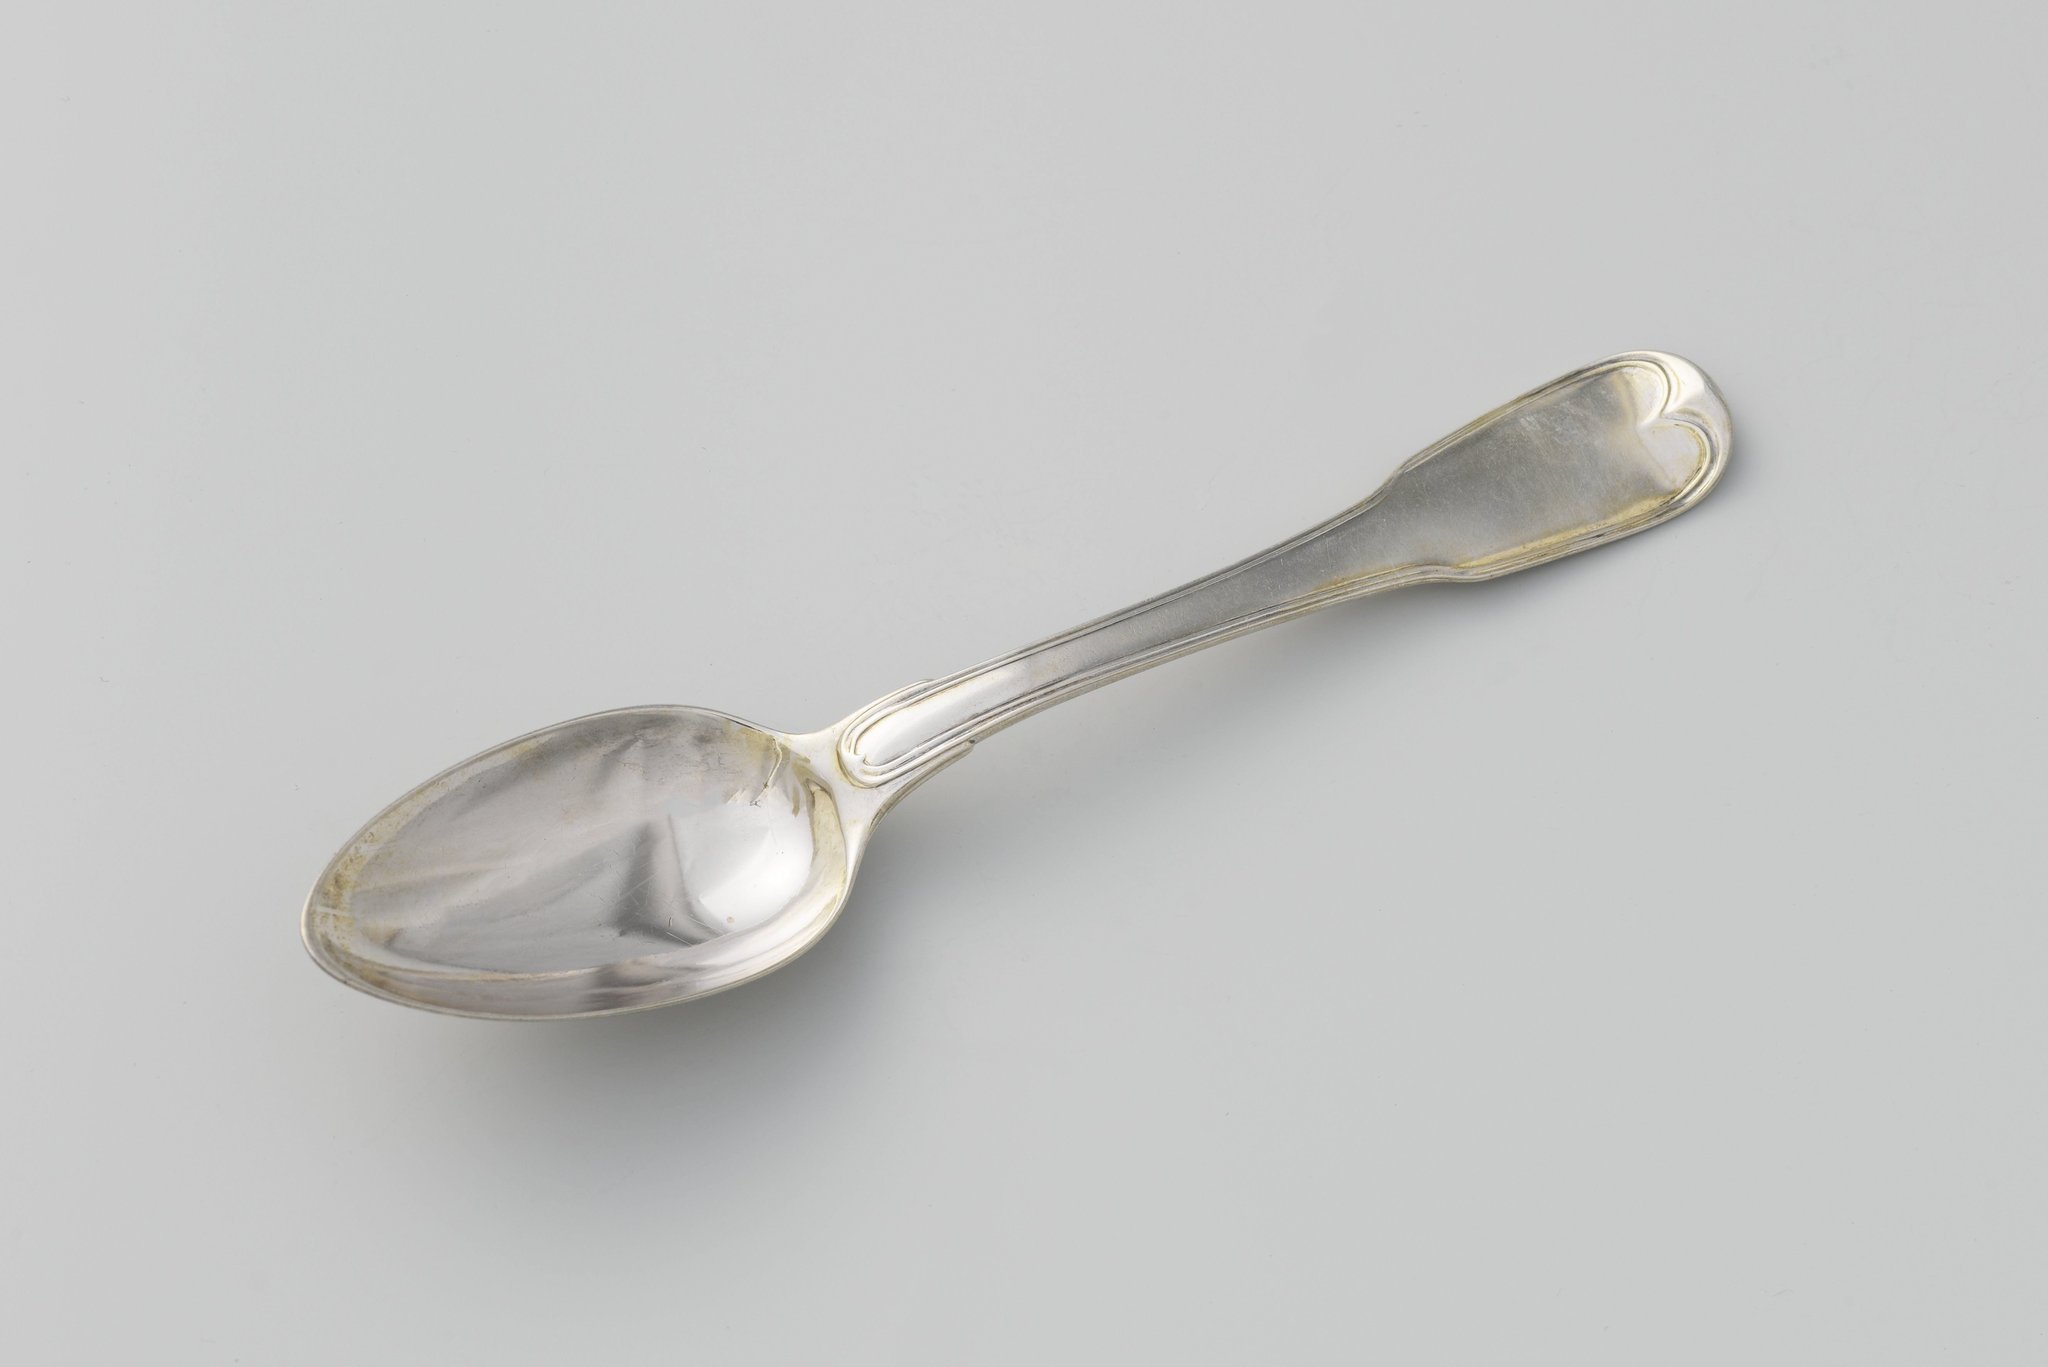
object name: spoon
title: Lepel met het helmteken Clifford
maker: roelof helweg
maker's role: silversmith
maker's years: 1758-1843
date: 1806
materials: silver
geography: amsterdam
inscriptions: alloy mark: ‘Hollandse leeuw’, maker's mark: ‘RH in ovaal’, town mark: ‘Amsterdam’, date letter: ‘X (=1806)’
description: De eivormige bak van de lepel is aan zowel boven- als onderzijde door middel van enkel lof verbonden met de platte, gebogen steel, die zich verbreedt naar het spatelvormige uiteinde. Boven- en onderzijde van de steel worden omgeven door een dubbele filetrand, die bij het uiteinde ingezwenkt is. Op de onderzijde van de spatel is het helmteken Clifford gegraveerd.